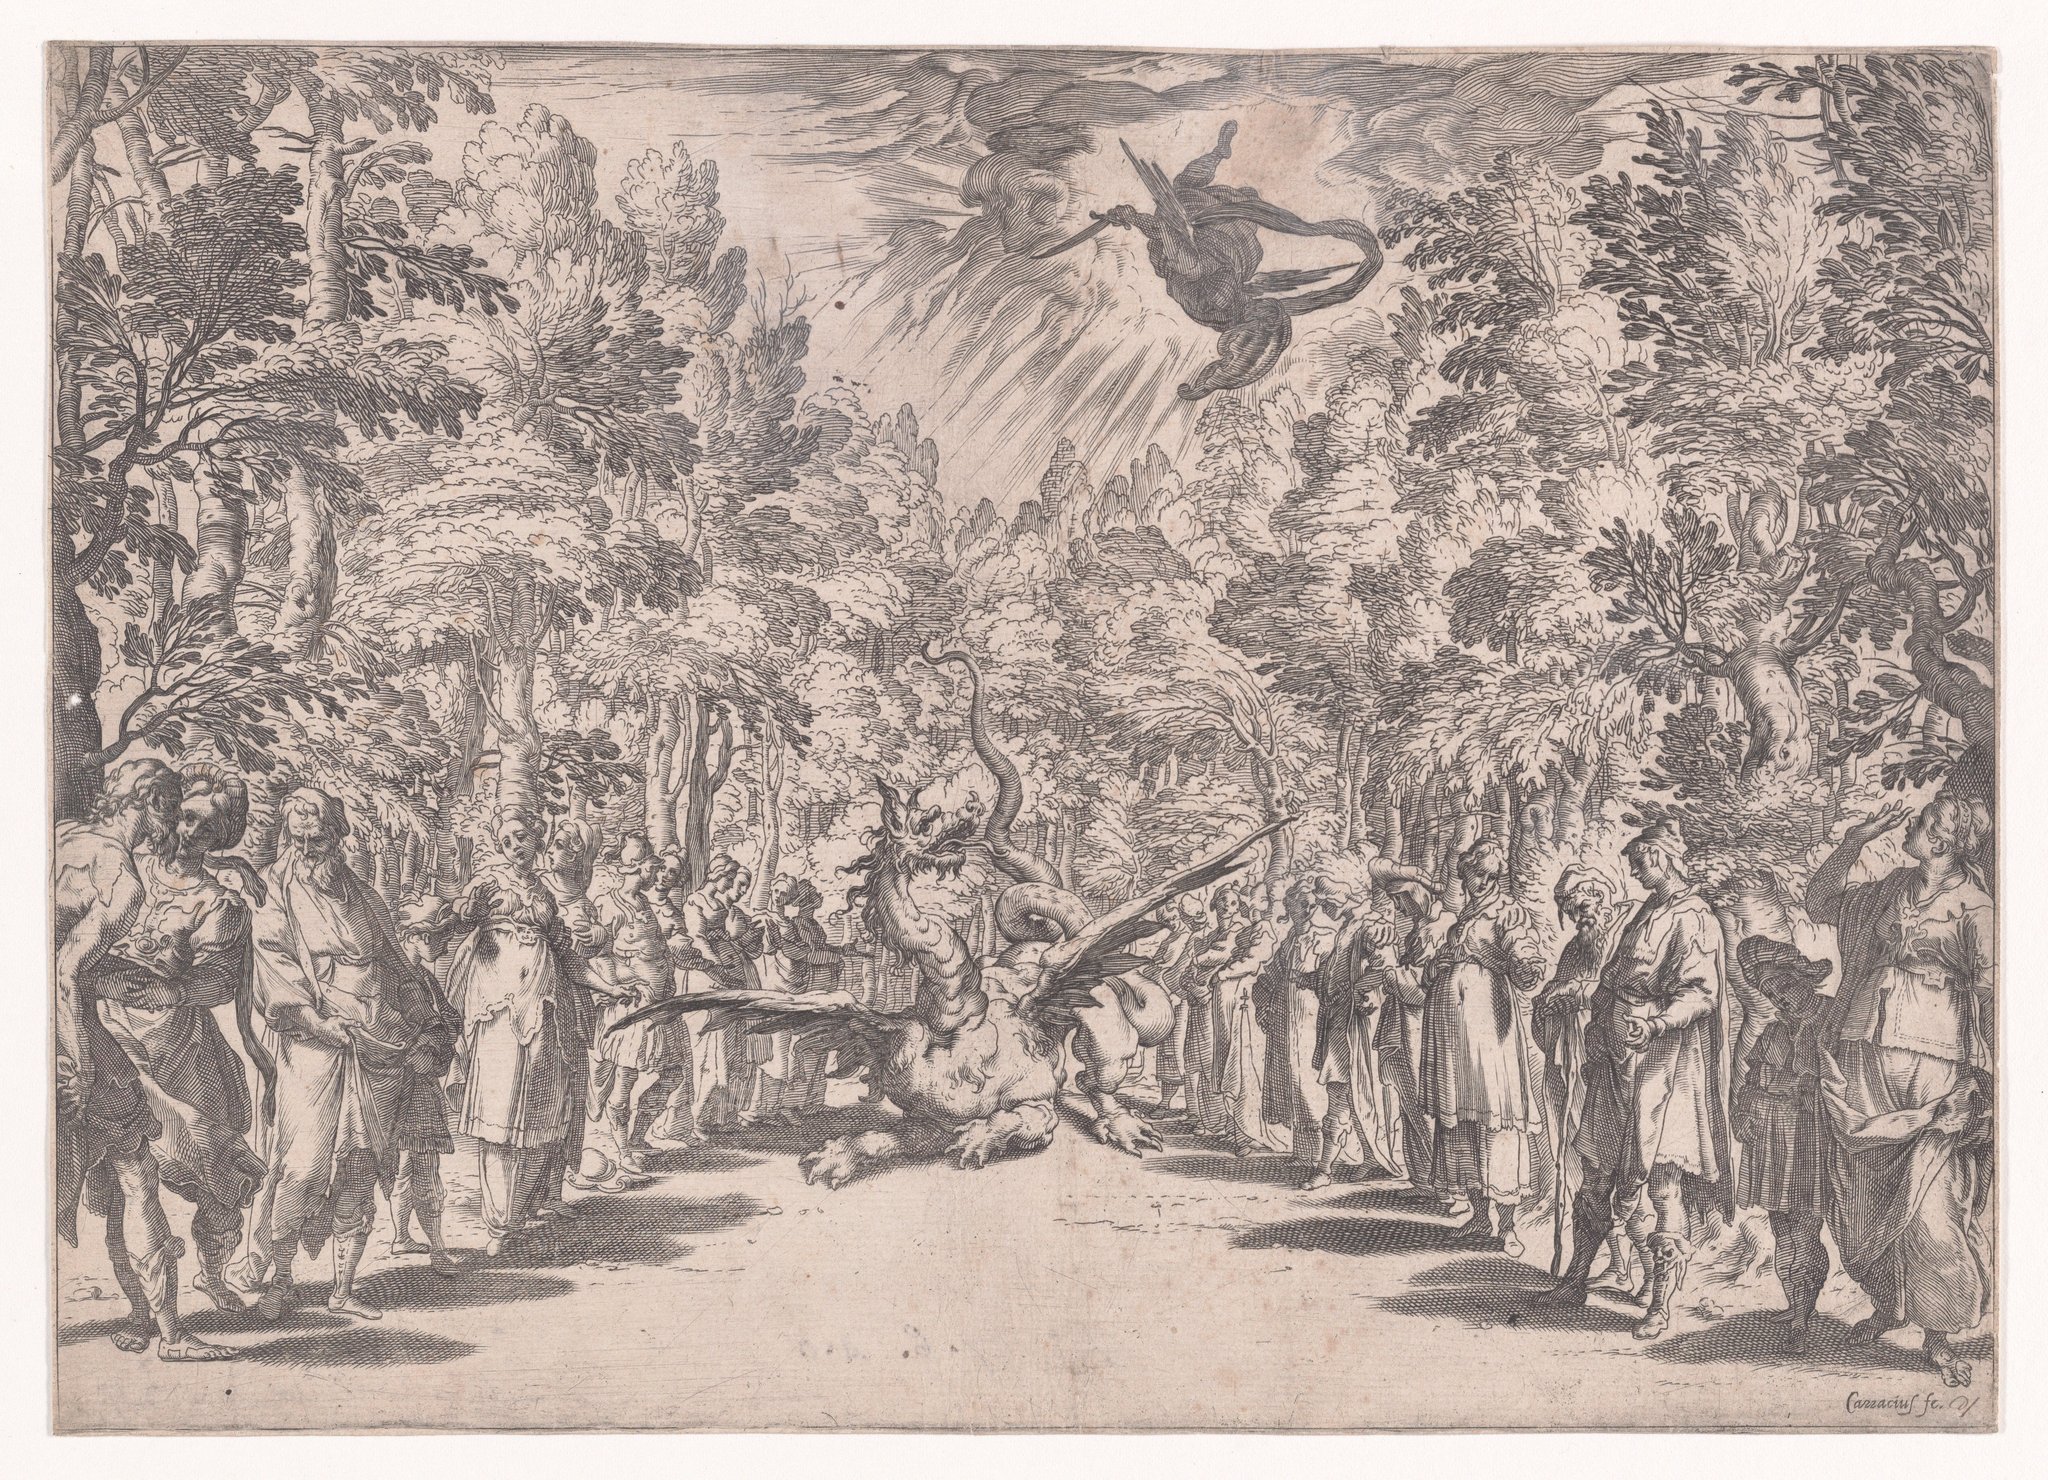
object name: print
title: Stage set for the marriage of Ferdinand de' Medici and Christine of Lorraine in Florence in 1589; Apollo and the Python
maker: agostino carracci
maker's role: artist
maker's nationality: italian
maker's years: 1557-1602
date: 1589-1592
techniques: engraving, etching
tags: men,women,dragons